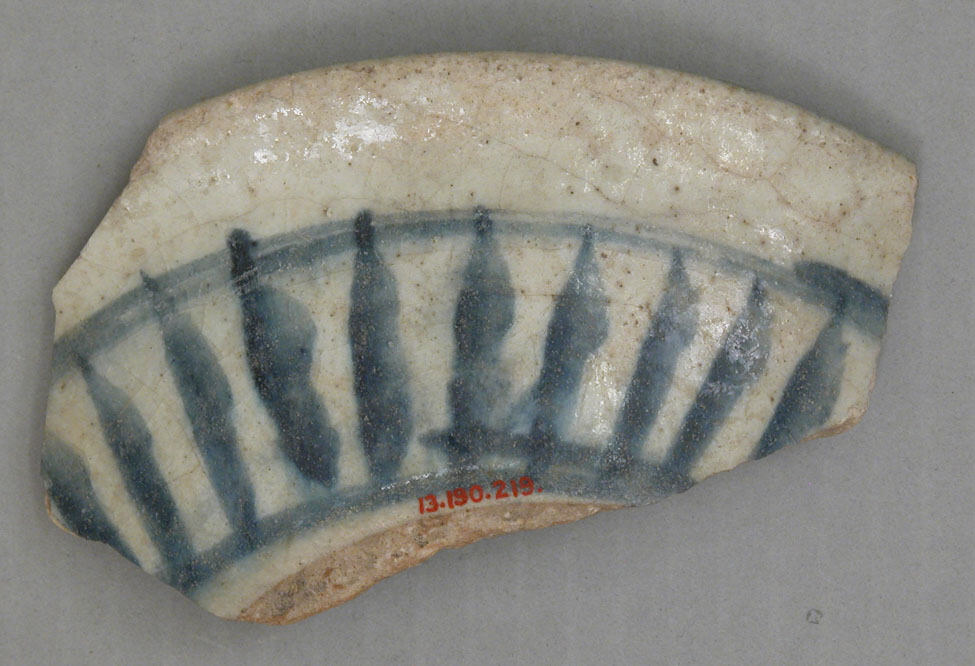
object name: ceramic fragment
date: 1301-1400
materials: glaze, stonepaste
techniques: painting, polychrome, underglaze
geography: syria